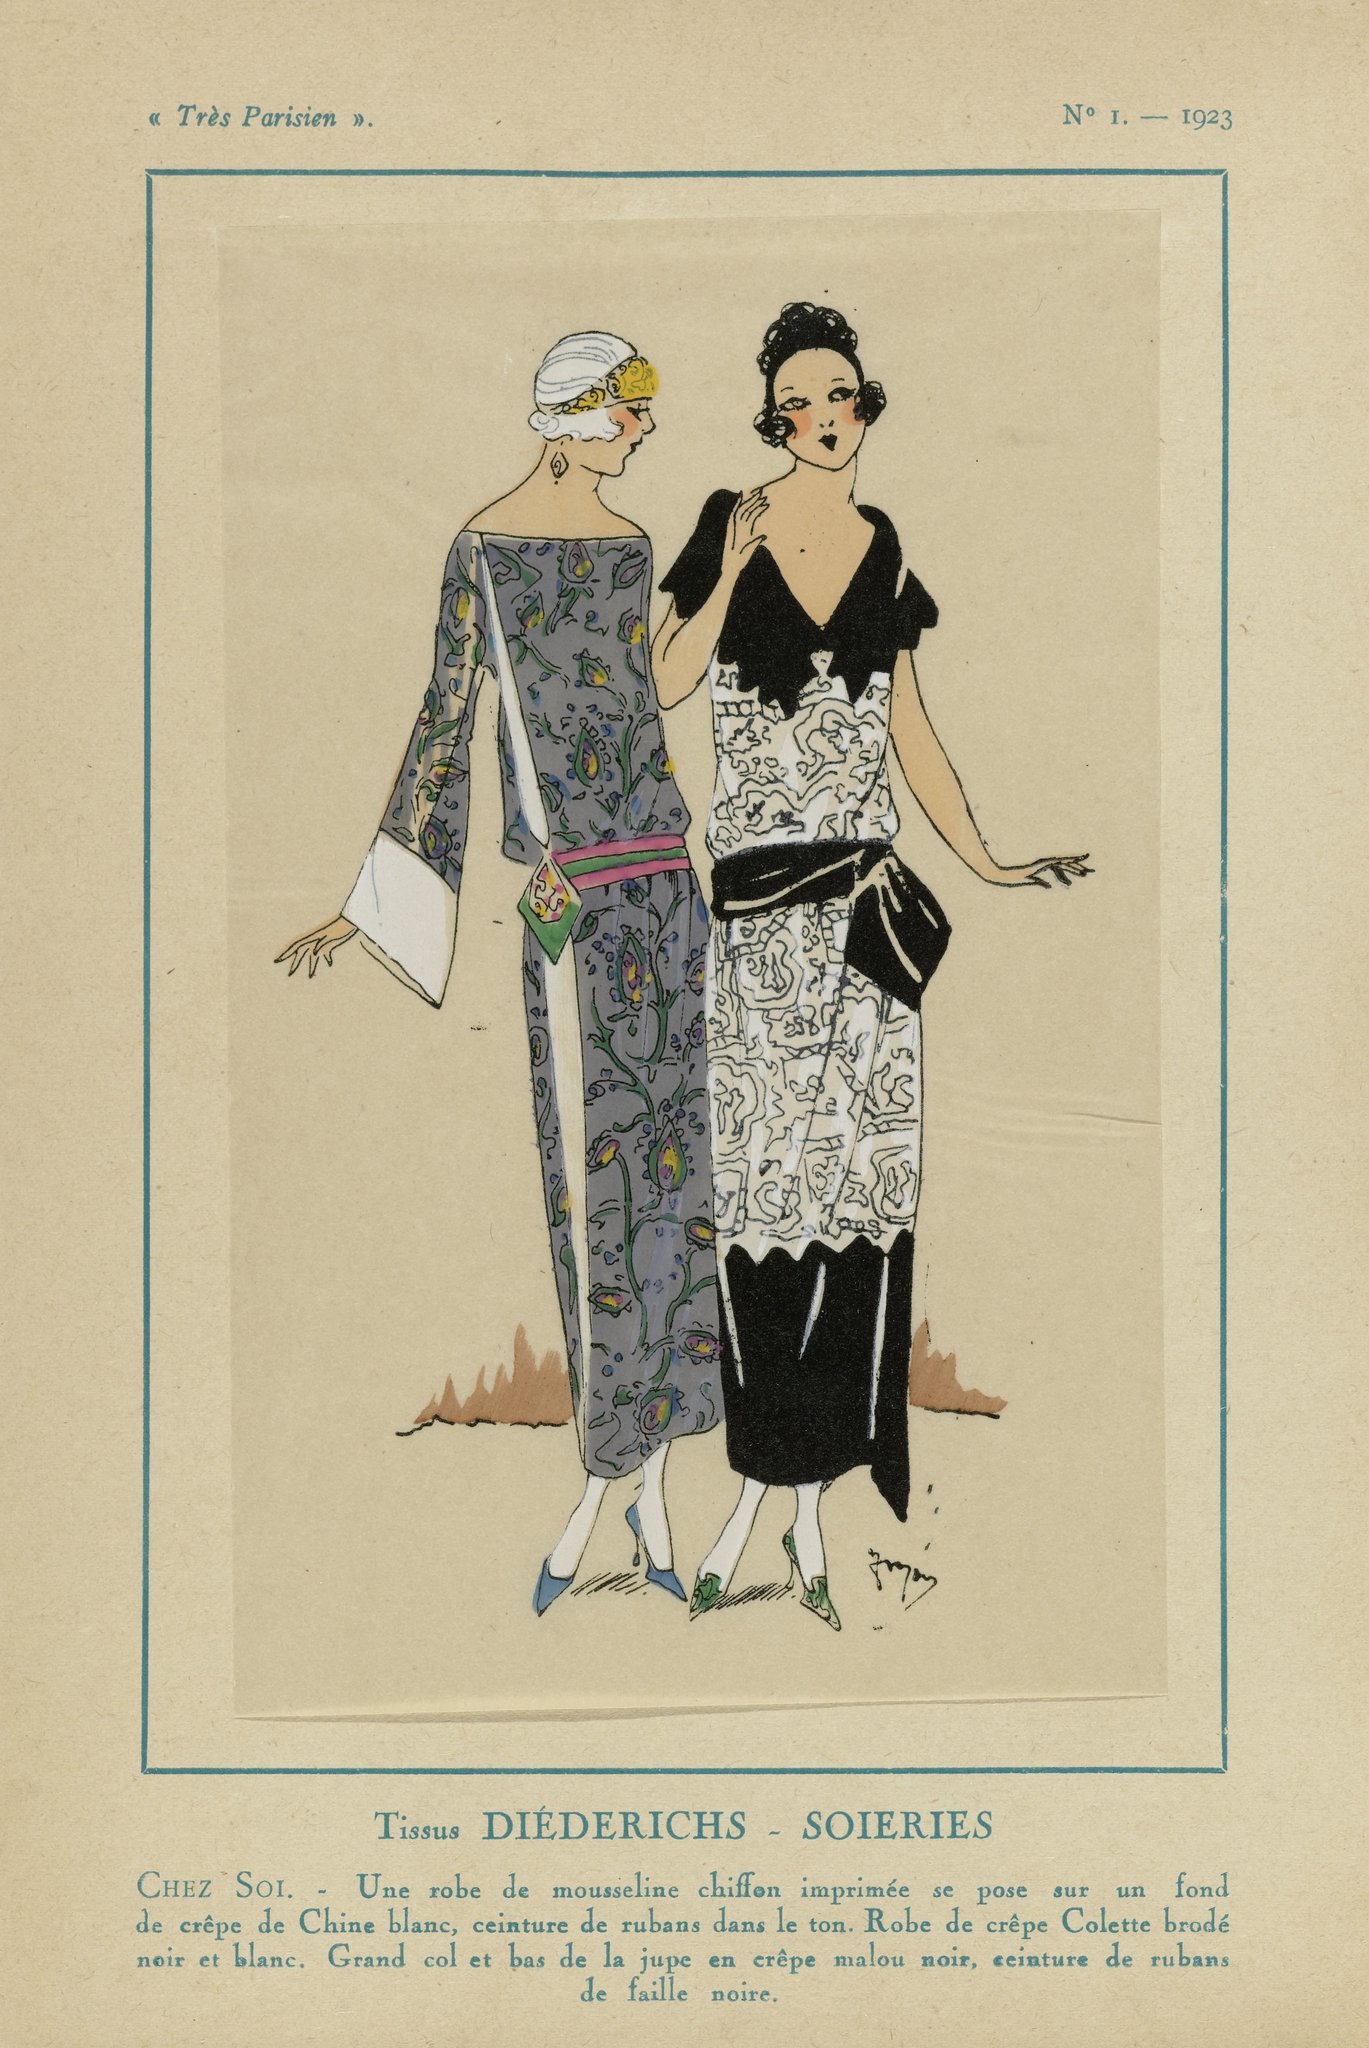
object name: fashion print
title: Très Parisien, 1923, No. 1: Tissus DIÉDERICHS- SOIERIES...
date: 1923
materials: paper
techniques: hand coloring, letterpress printing, lithography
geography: paris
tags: diadem, tiara (+ women's clothes), embroidery (ornamentation) (+ women's clothes), border, ribbon, braid (+ women's clothes), neck-gear: collar (+ women's clothes), fashion plates, dress, gown (+ women's clothes), belt, girdle, waistband (+ women's clothes)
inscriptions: title: ‘Très Parisien / No 1. - 1923’, caption: ‘Tissus DIÉDERICHS-SOIERIES / CHEZ SOI. - Une robe de mousseline chiffon imprimée se pose sur un fond de crêpe de Chine blanc, ceinture de rubans dans le ton. Robe de crêpe Colette brodé noir et blanc. Grand col et bas de la jupe en crêpe malou noir, ceinture de rubans de faille noire.’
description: Links een japon van mousseline; rechts een japon van crèpe. Beide gemaakt met stoffen van DIÉDERICHS-SOIERIES. Prent uit het modetijdschrift Très Parisien (1920-1936).